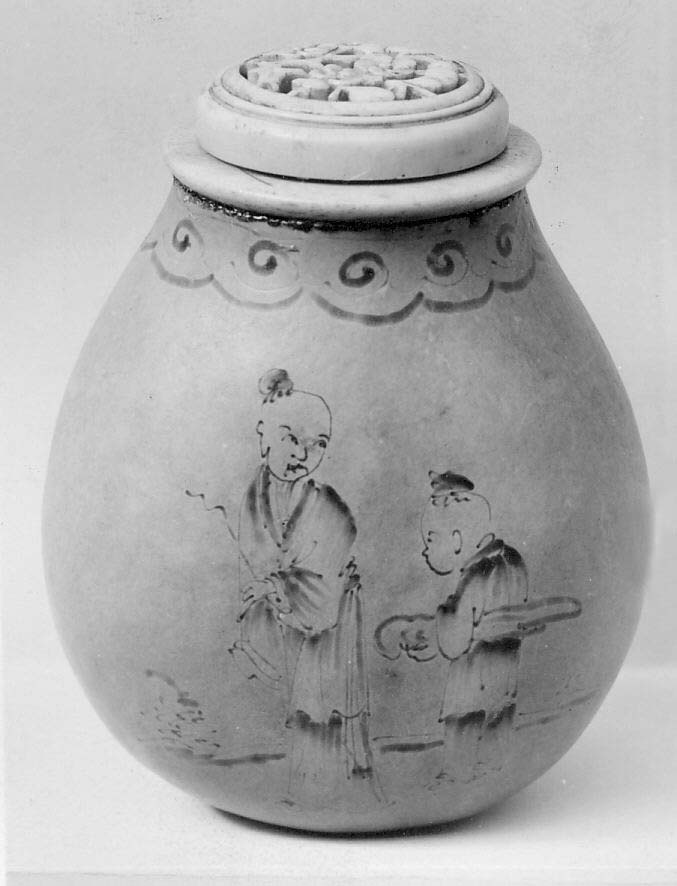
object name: cricket cage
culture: chinese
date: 1701-1900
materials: ivory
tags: boys,men